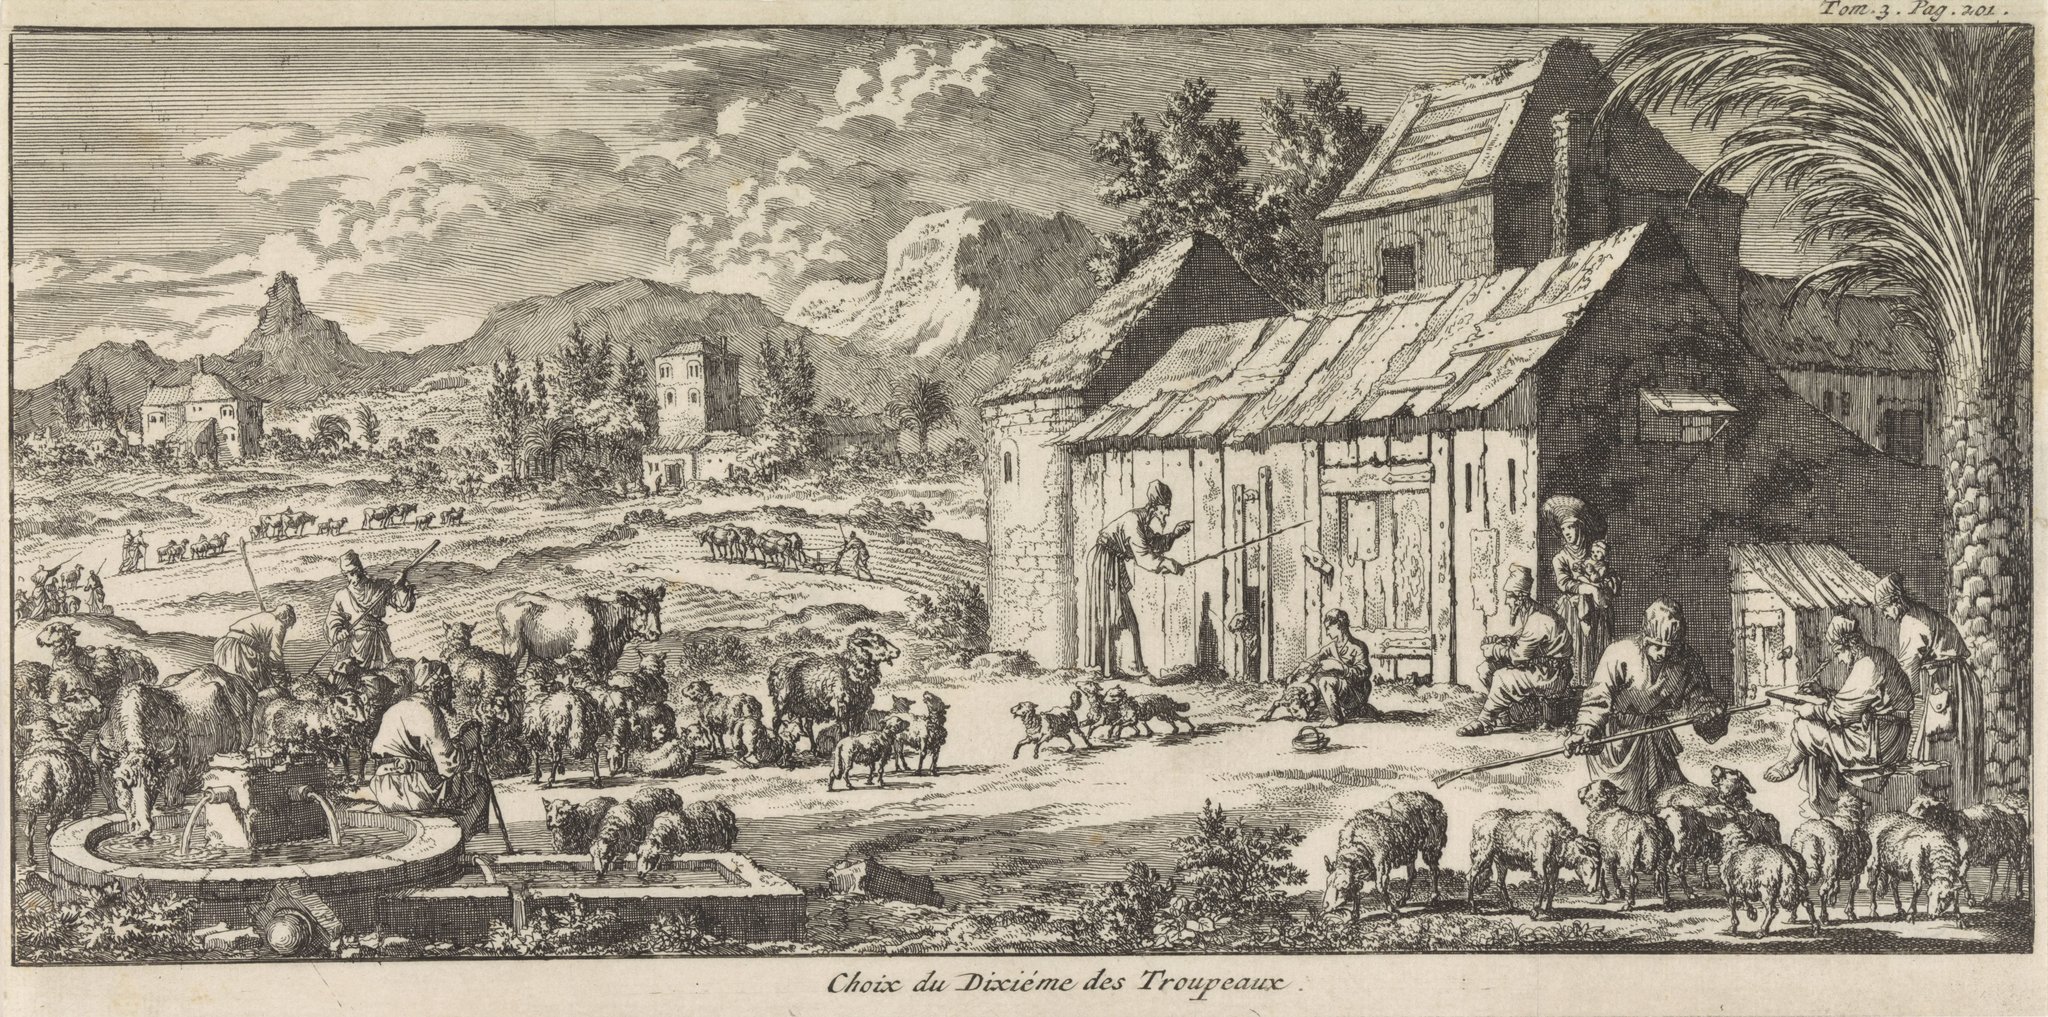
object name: print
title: Choix du Dixiéme des Troupeaux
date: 1705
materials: paper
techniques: etching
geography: amsterdam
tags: biblical laws, justice and government ~ jewish religion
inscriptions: collector's mark: Lugt 2228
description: Illustratie uit: Cunaeus, Petrus. La republique des Hebreux, 3 delen. Amsterdam: Pieter Mortier, 1705, dl. III, p. 201.